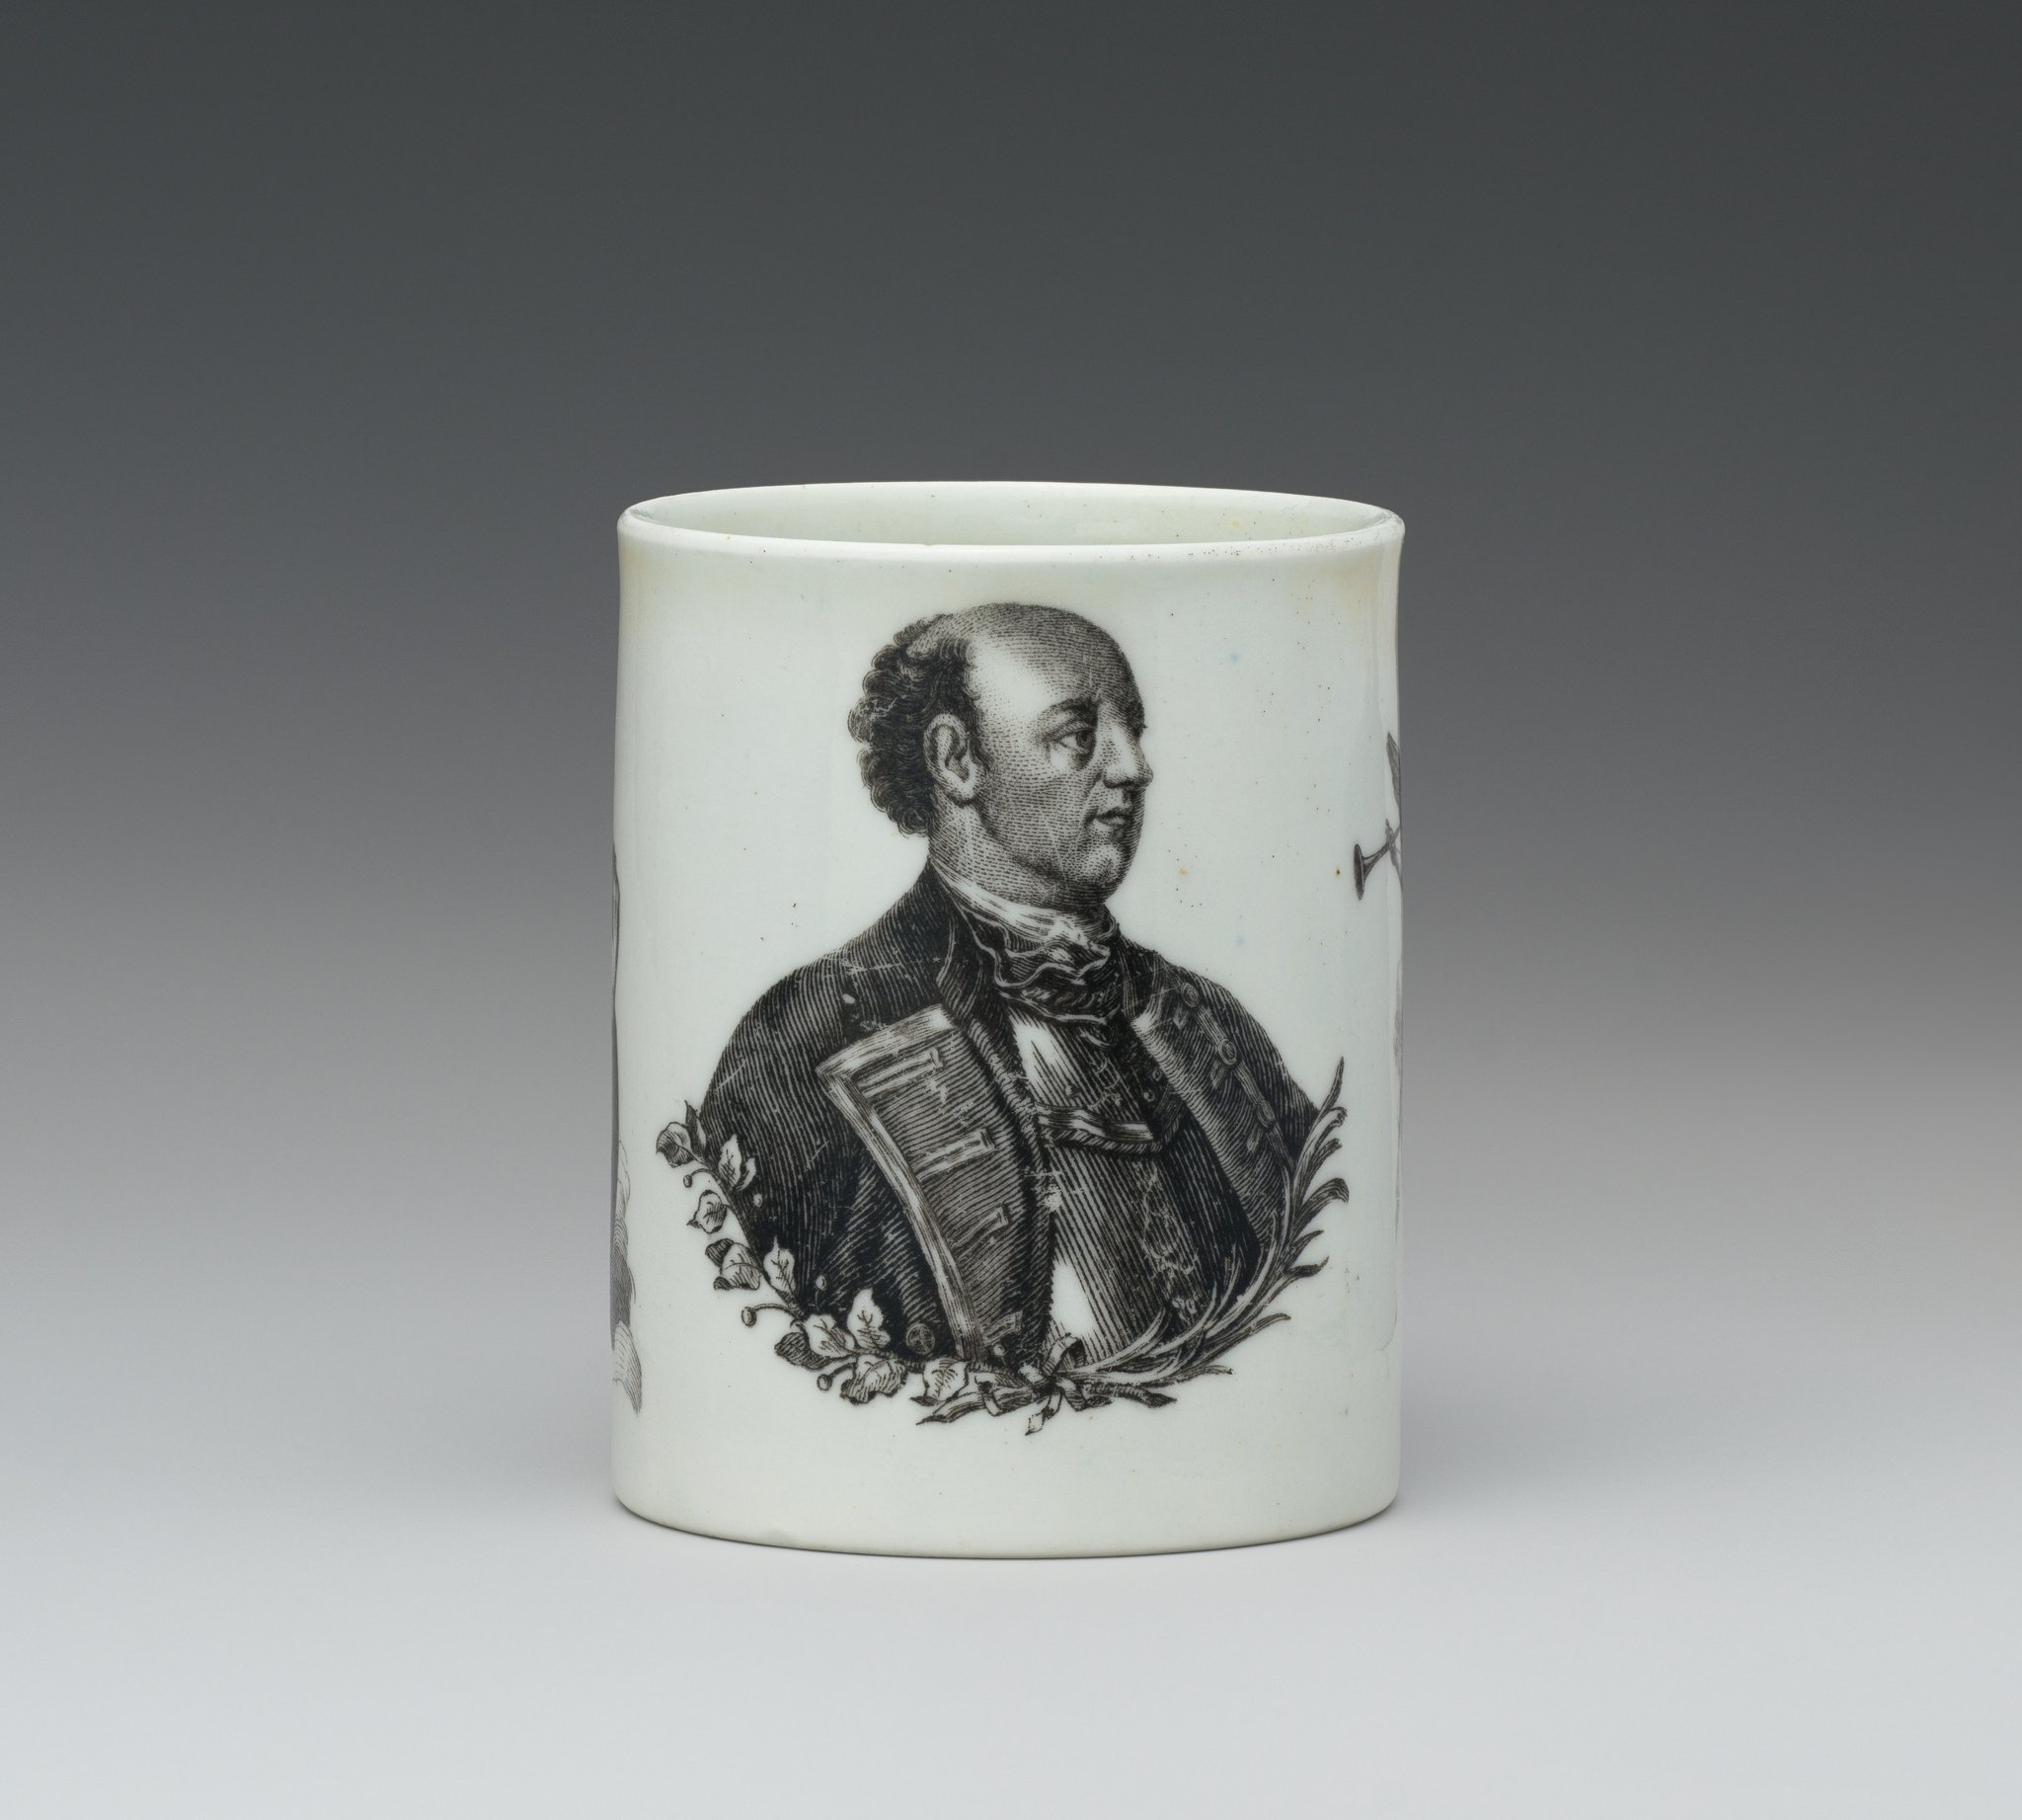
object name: mug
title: Mug with portrait of General John Manners (1721–1770), Marquis of Granby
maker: worcester factory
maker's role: factory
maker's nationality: british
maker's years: 1751-2008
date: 1760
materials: soft paste porcelain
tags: men